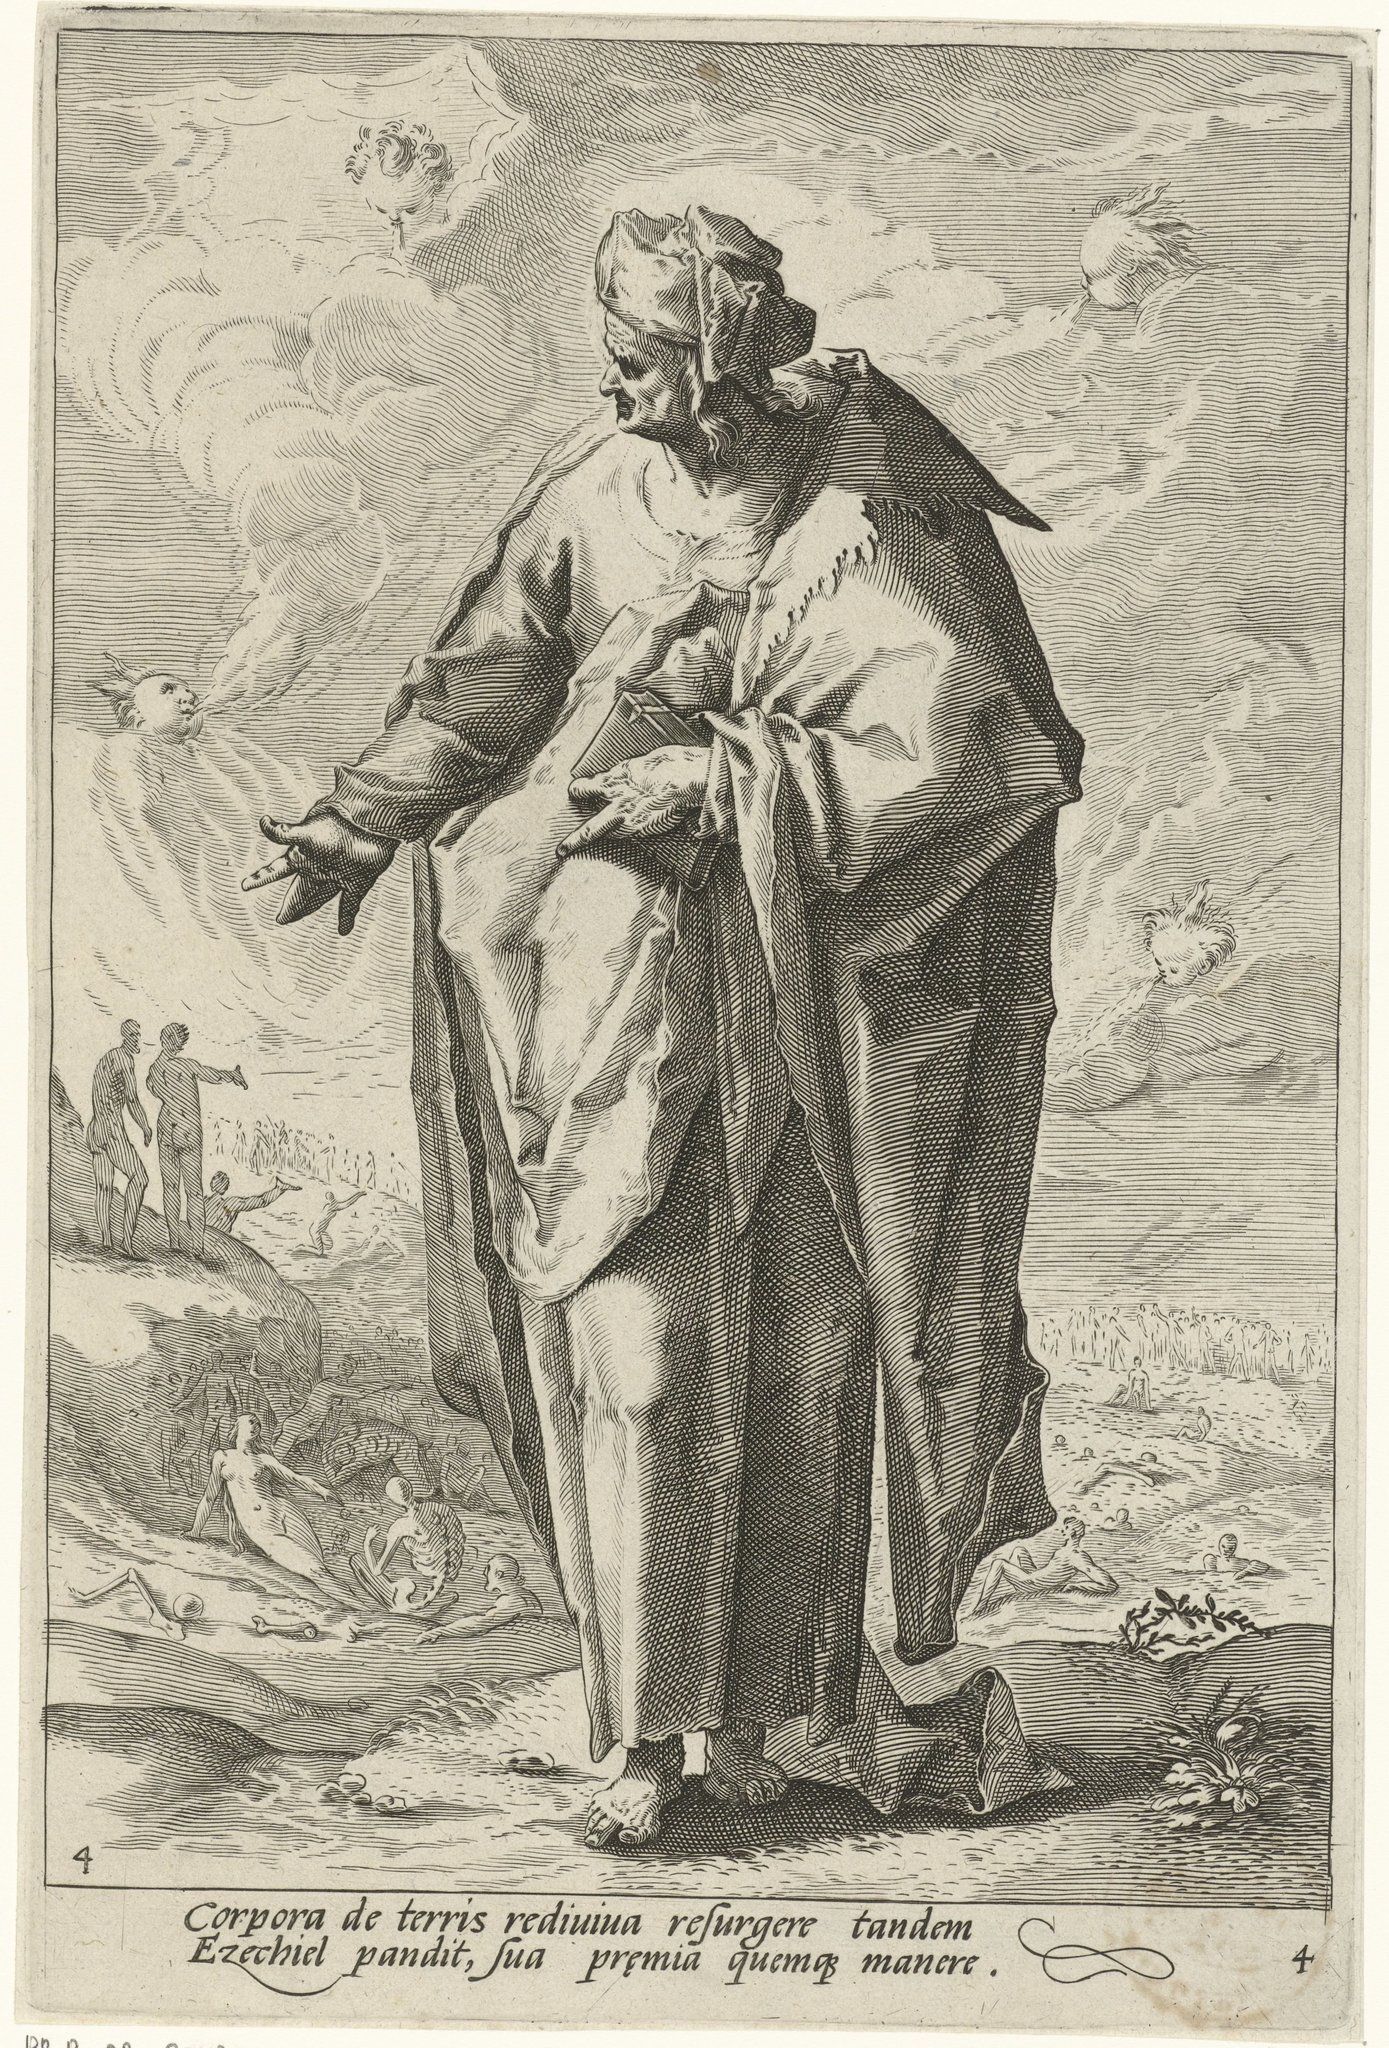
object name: print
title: Profeten van het Oude Testament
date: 1589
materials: paper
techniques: engraving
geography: amsterdam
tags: resurrection: life is breathed into the bodies ~ ezekiel's visions, ezekiel (not in biblical context); possible attributes: book or scroll, double wheel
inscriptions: collector's mark: Lugt 240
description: De profeet Ezechiël met achter hem zijn visioen over de opstanding, waarbij leven wordt geblazen in de doden. Vierde prent uit de serie van de profeten en de profetessen uit het Oude Testament samengevoegd.